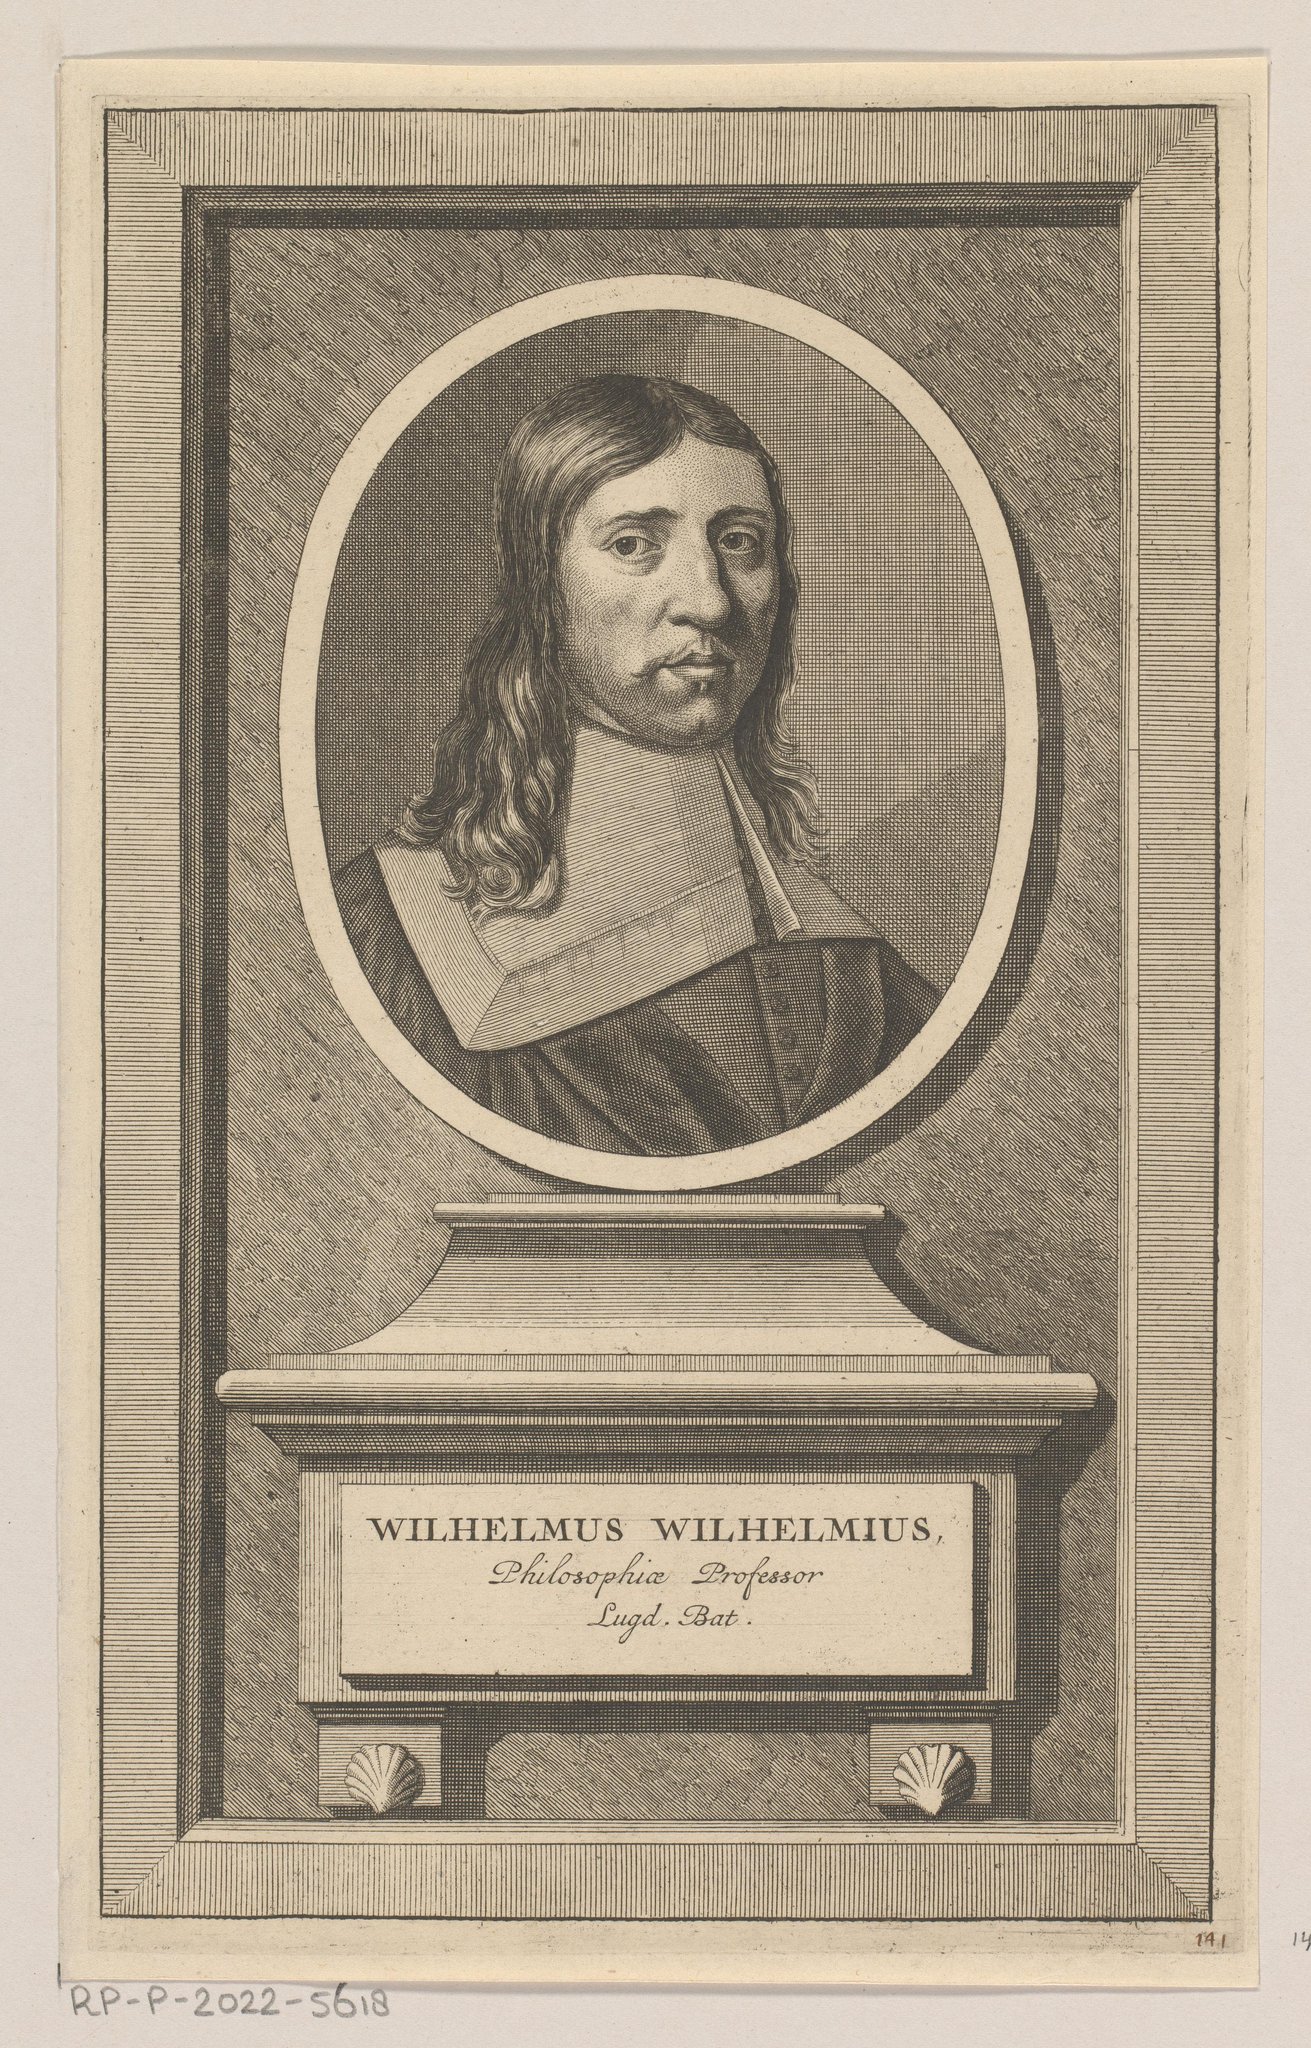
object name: print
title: Beroemde mannen aan de universiteit van Leiden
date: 1716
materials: paper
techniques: etching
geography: leiden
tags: historical persons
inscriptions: number: ‘141’